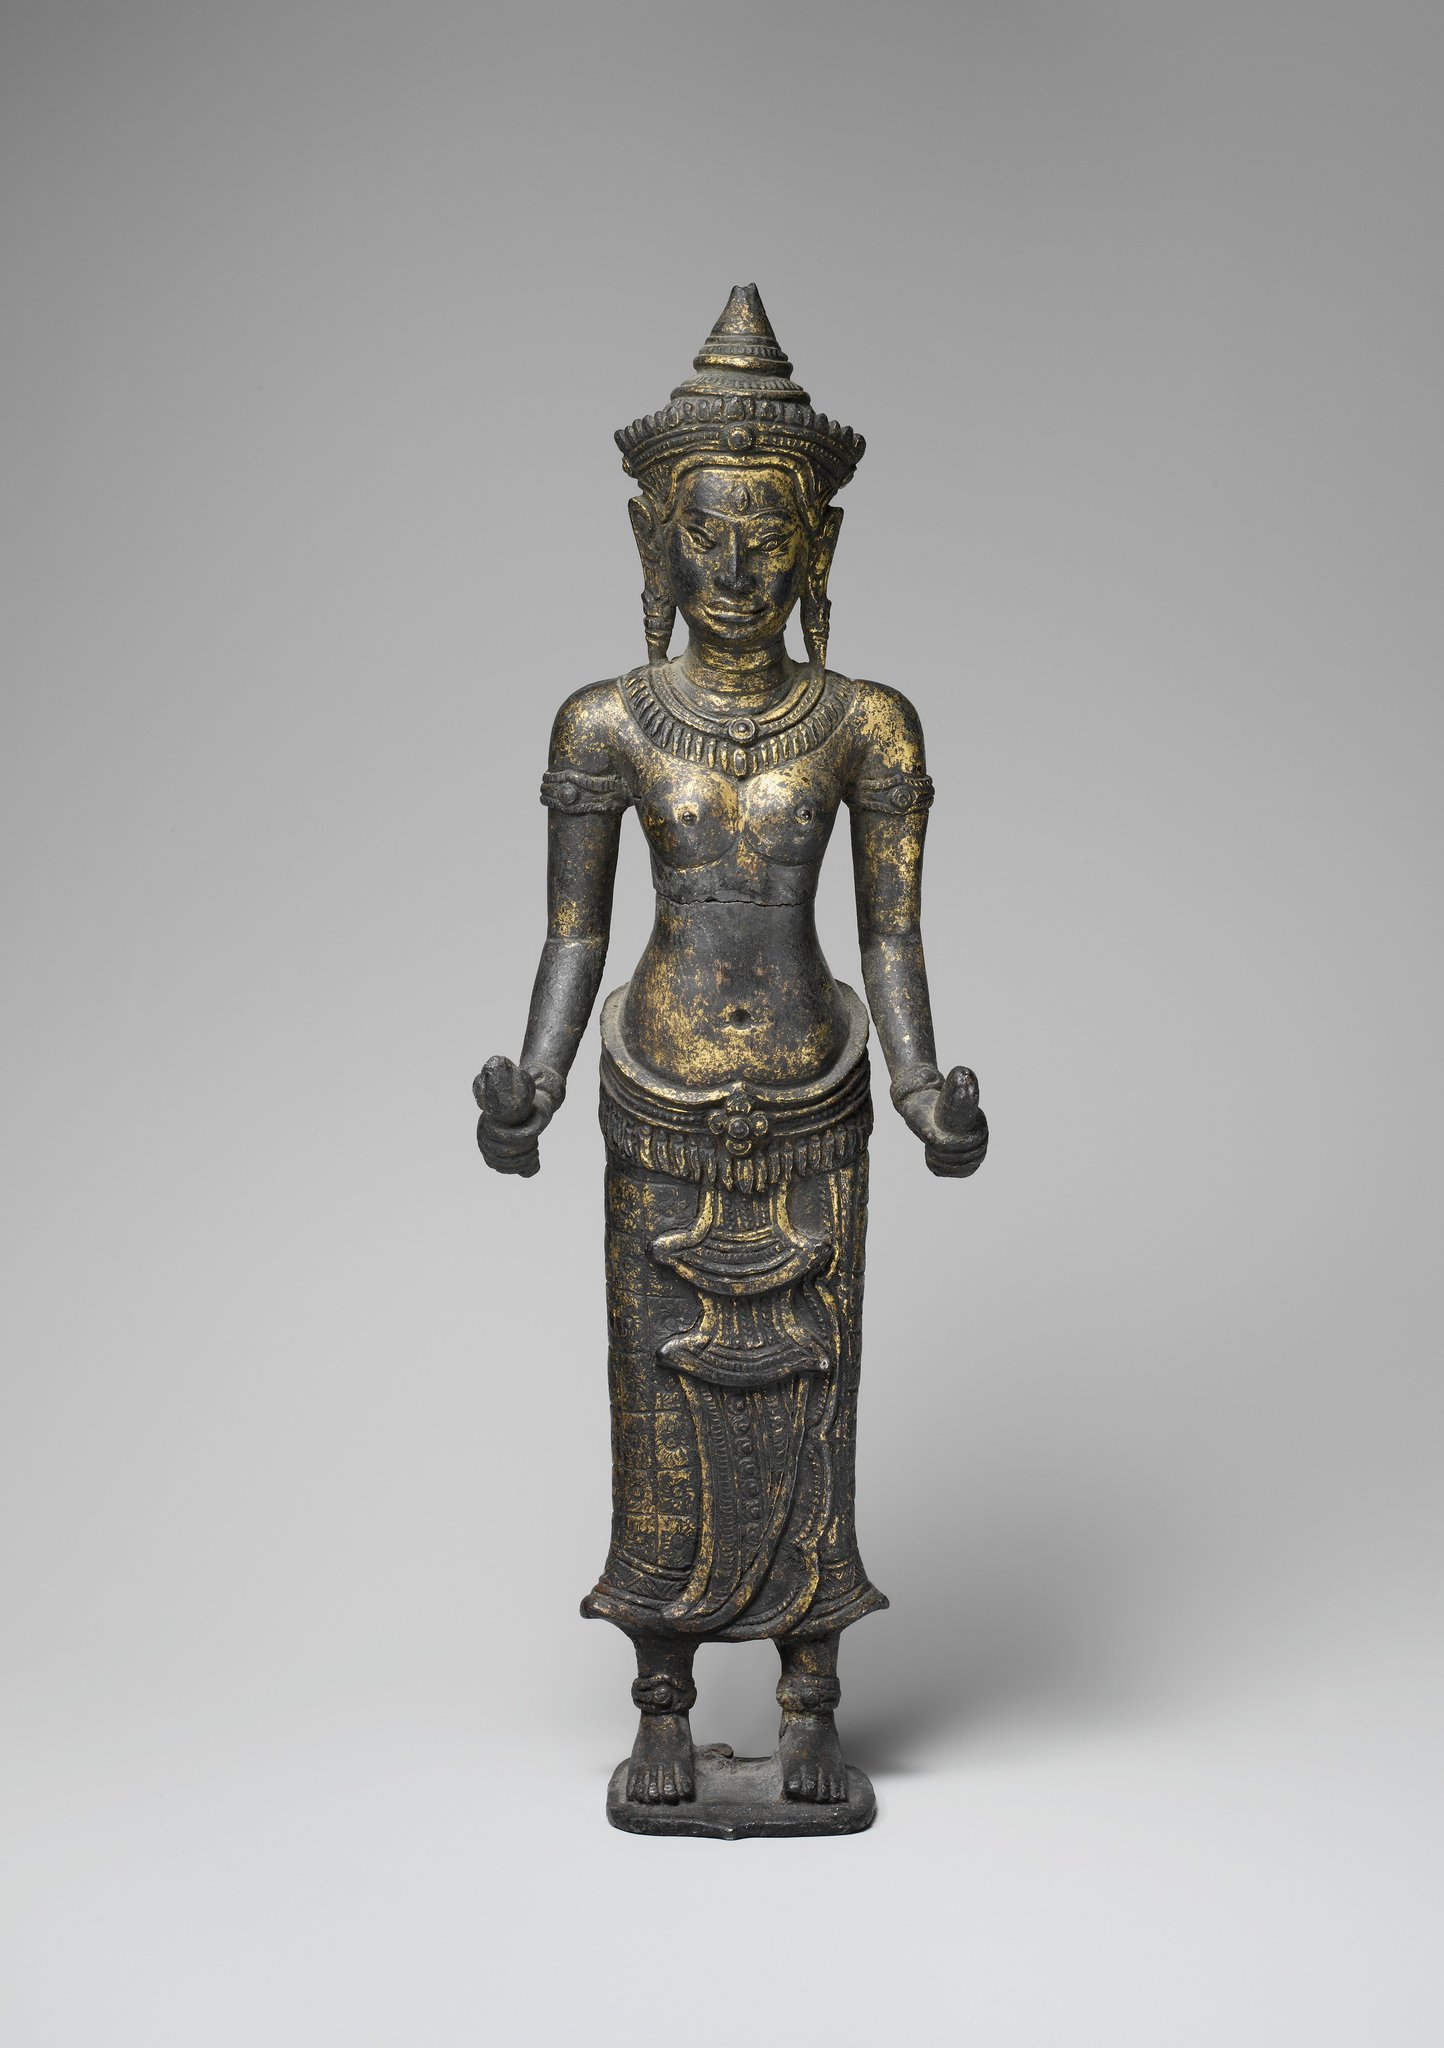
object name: figure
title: Standing Lakshmi(?)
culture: cambodian or thai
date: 1201-1300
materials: bronze, gilt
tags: hinduism